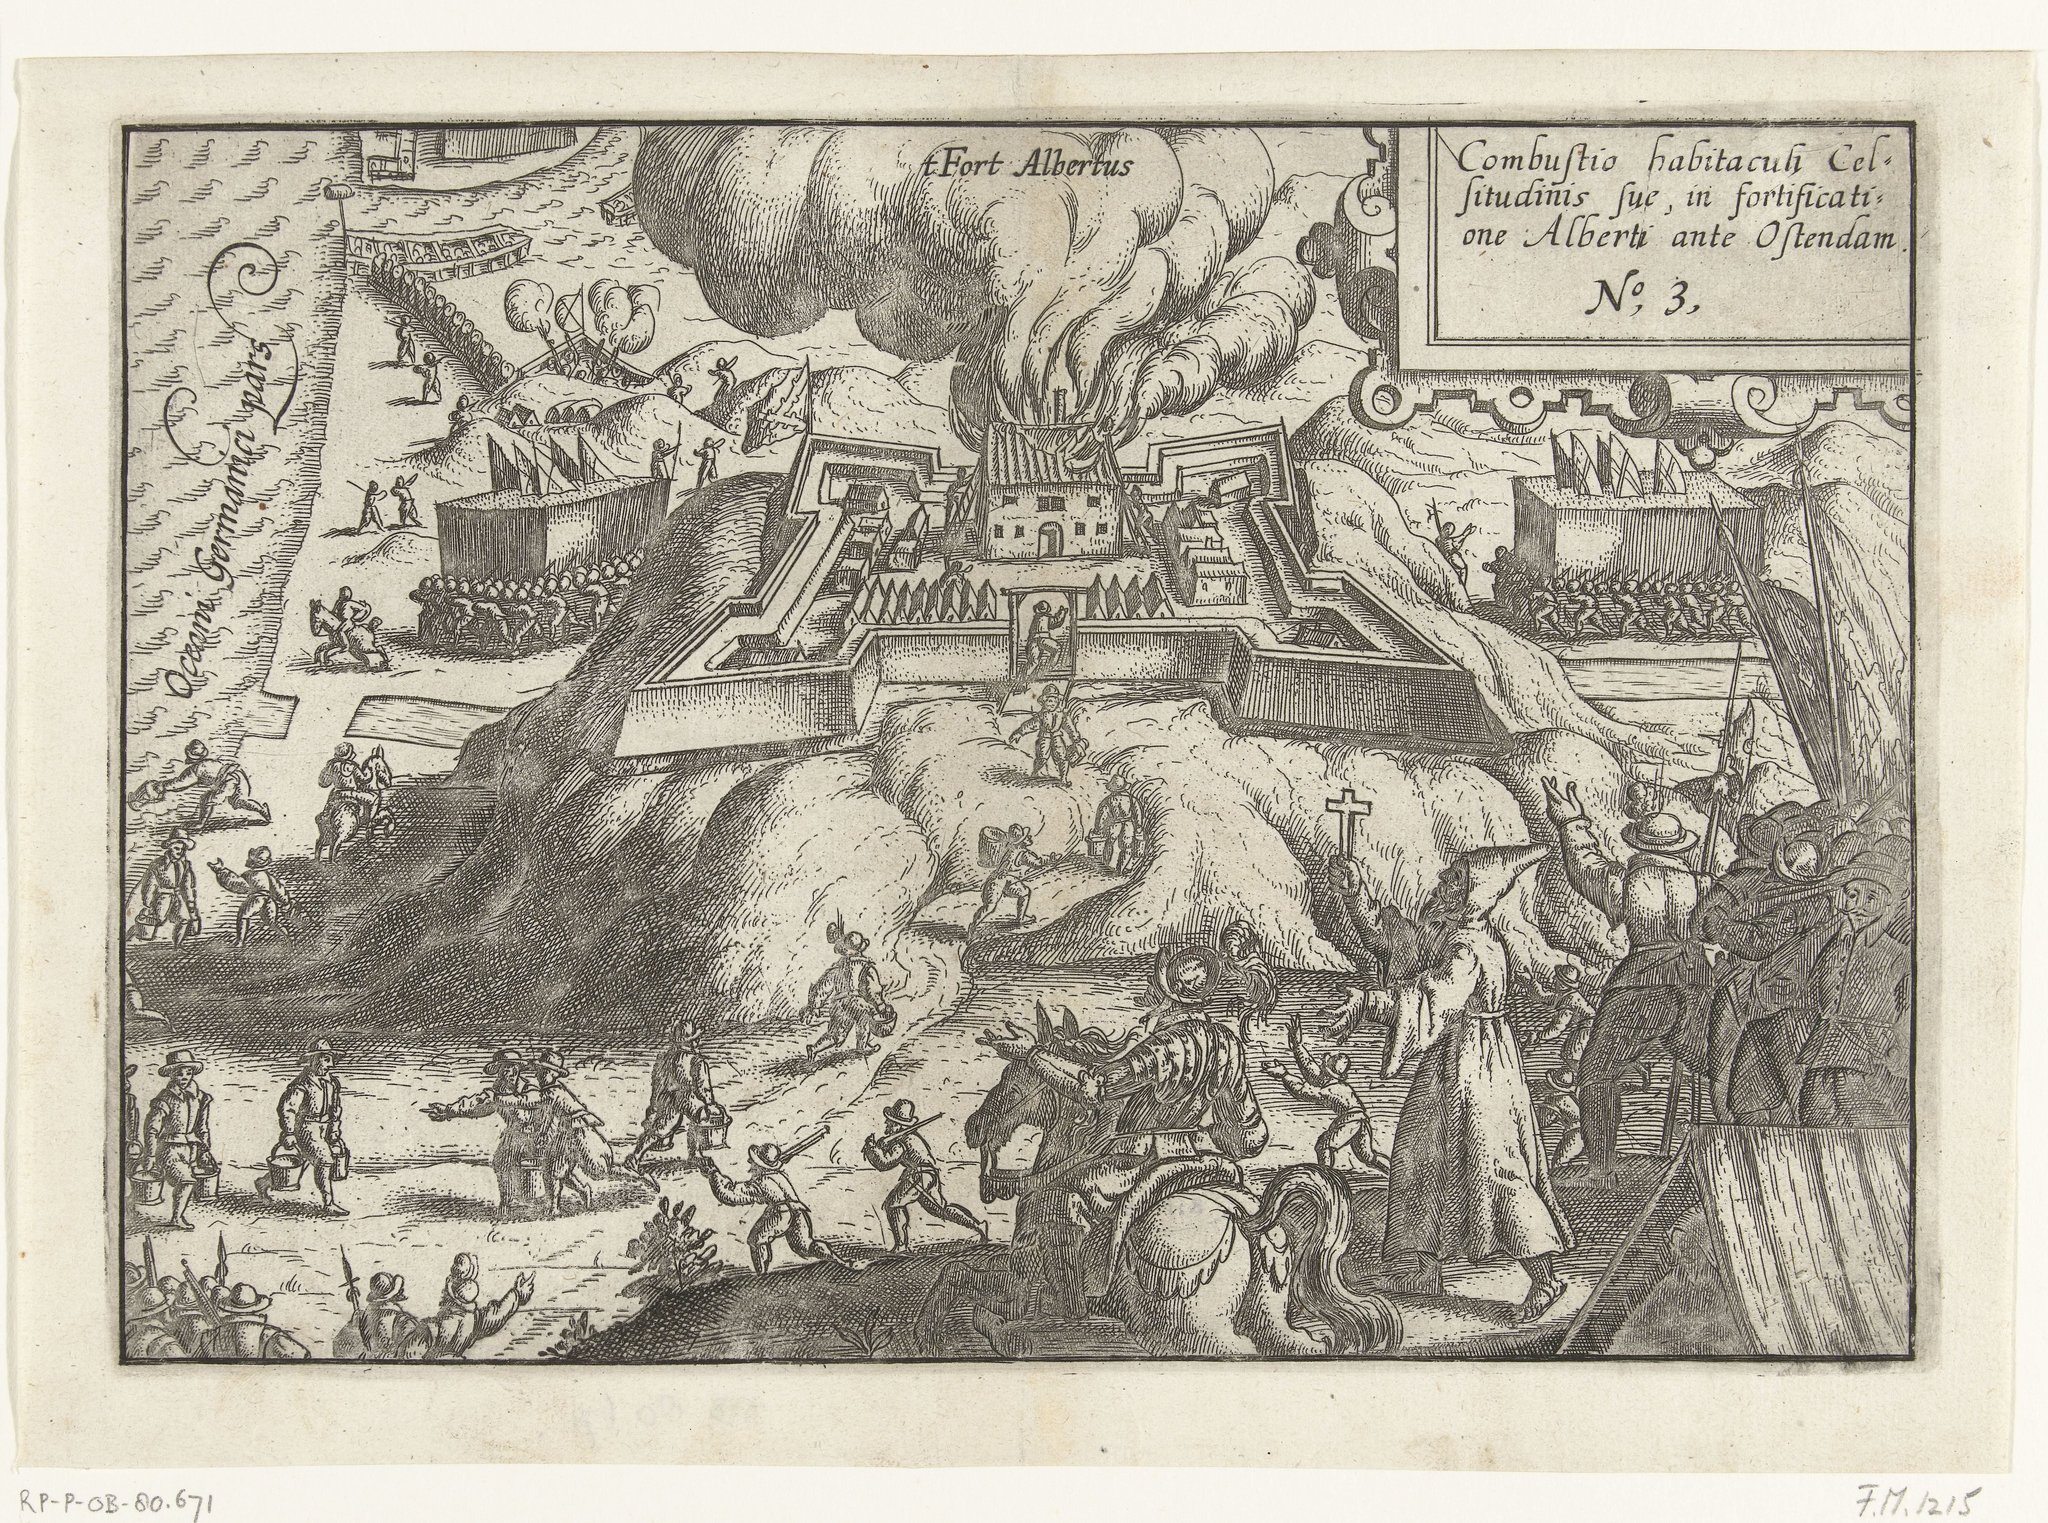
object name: print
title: Beleg van Oostende: brand in fort Albertus op 13 november 1601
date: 1601-1604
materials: paper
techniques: engraving, etching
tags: on fire, ablaze, siege, position war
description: Eerdere staat van prent ook gebruikt in contemporaine journalen van het beleg van Oostende uit 1604 (exemplaren in de collectie van de Rijksmuseum Research Library (326 F 10 en 326 F 11). En in: Haestens, Hendrick van. De Bloedige ende strenge Belegeringhe Der Stadt Oostende in Vlaenderen, Leiden: Hendrick van Haestens, 1613. Huidige staat van prent ook gebruikt in: Haestens, Hendrick van. La nouvelle Troye ou memorable histoire du siege d’Ostende. Leiden: Hendrick van Haestens, 1615.